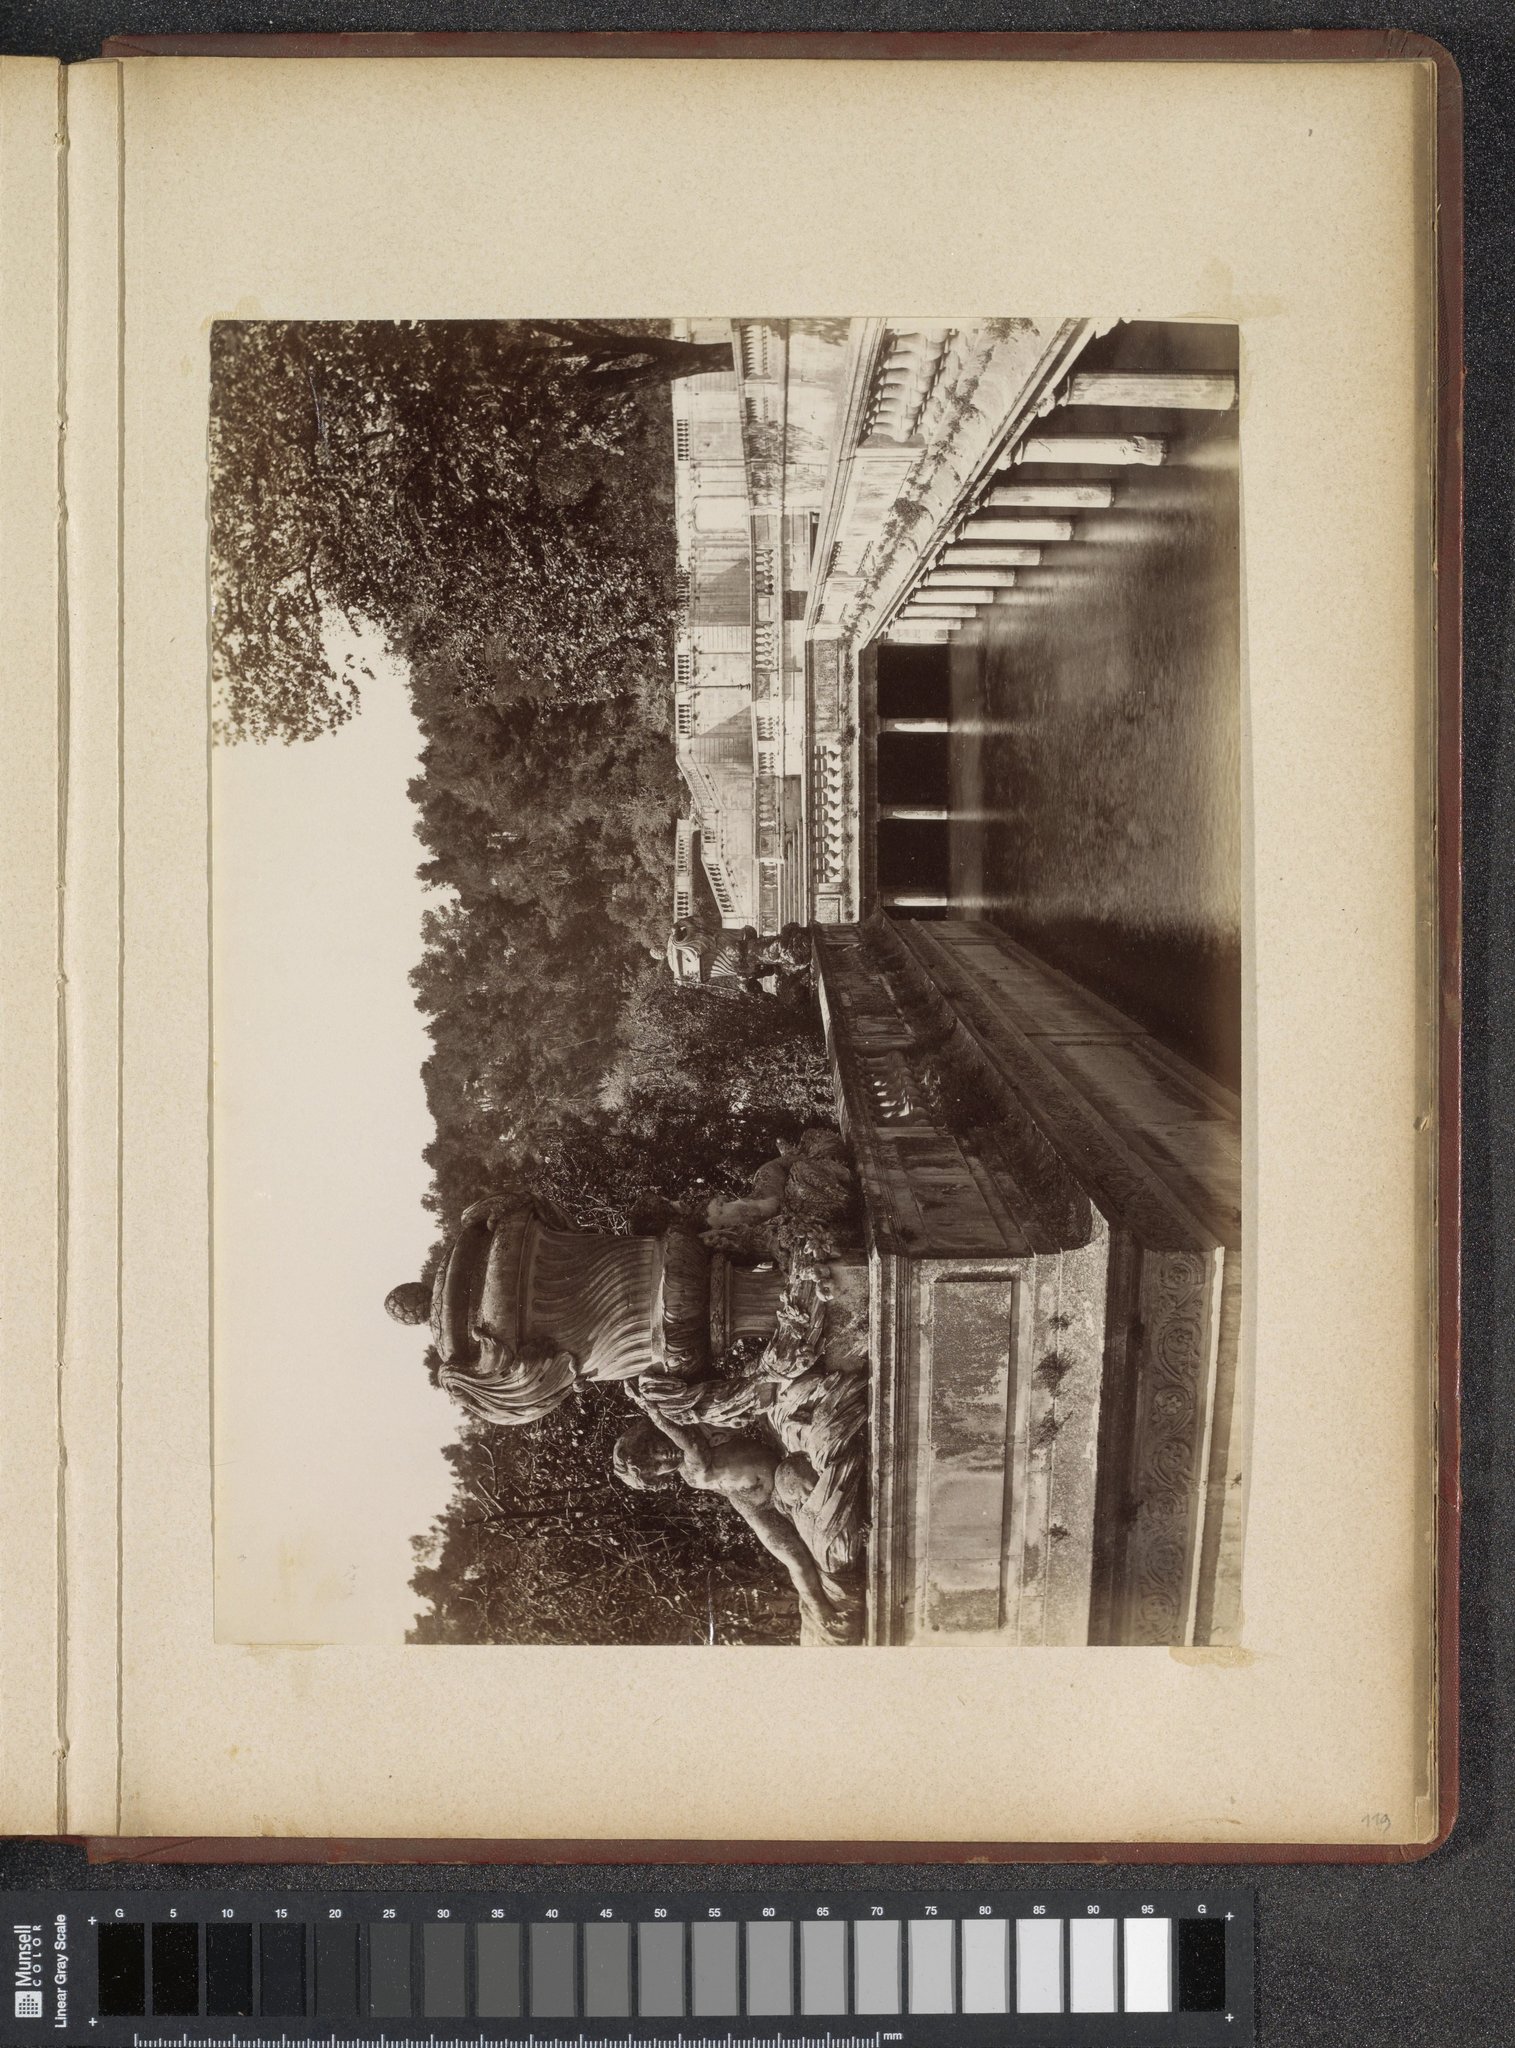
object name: album leaf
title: Romeinse baden in de Jardins de la Fontaine in Nîmes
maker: Anonymous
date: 1870-1900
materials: paper, photographic support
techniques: albumen print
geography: nîmes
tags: public baths, public gardens, park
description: Onderdeel van Reisalbum met foto's van bezienswaardigheden in Italië en Zuid-Frankrijk.